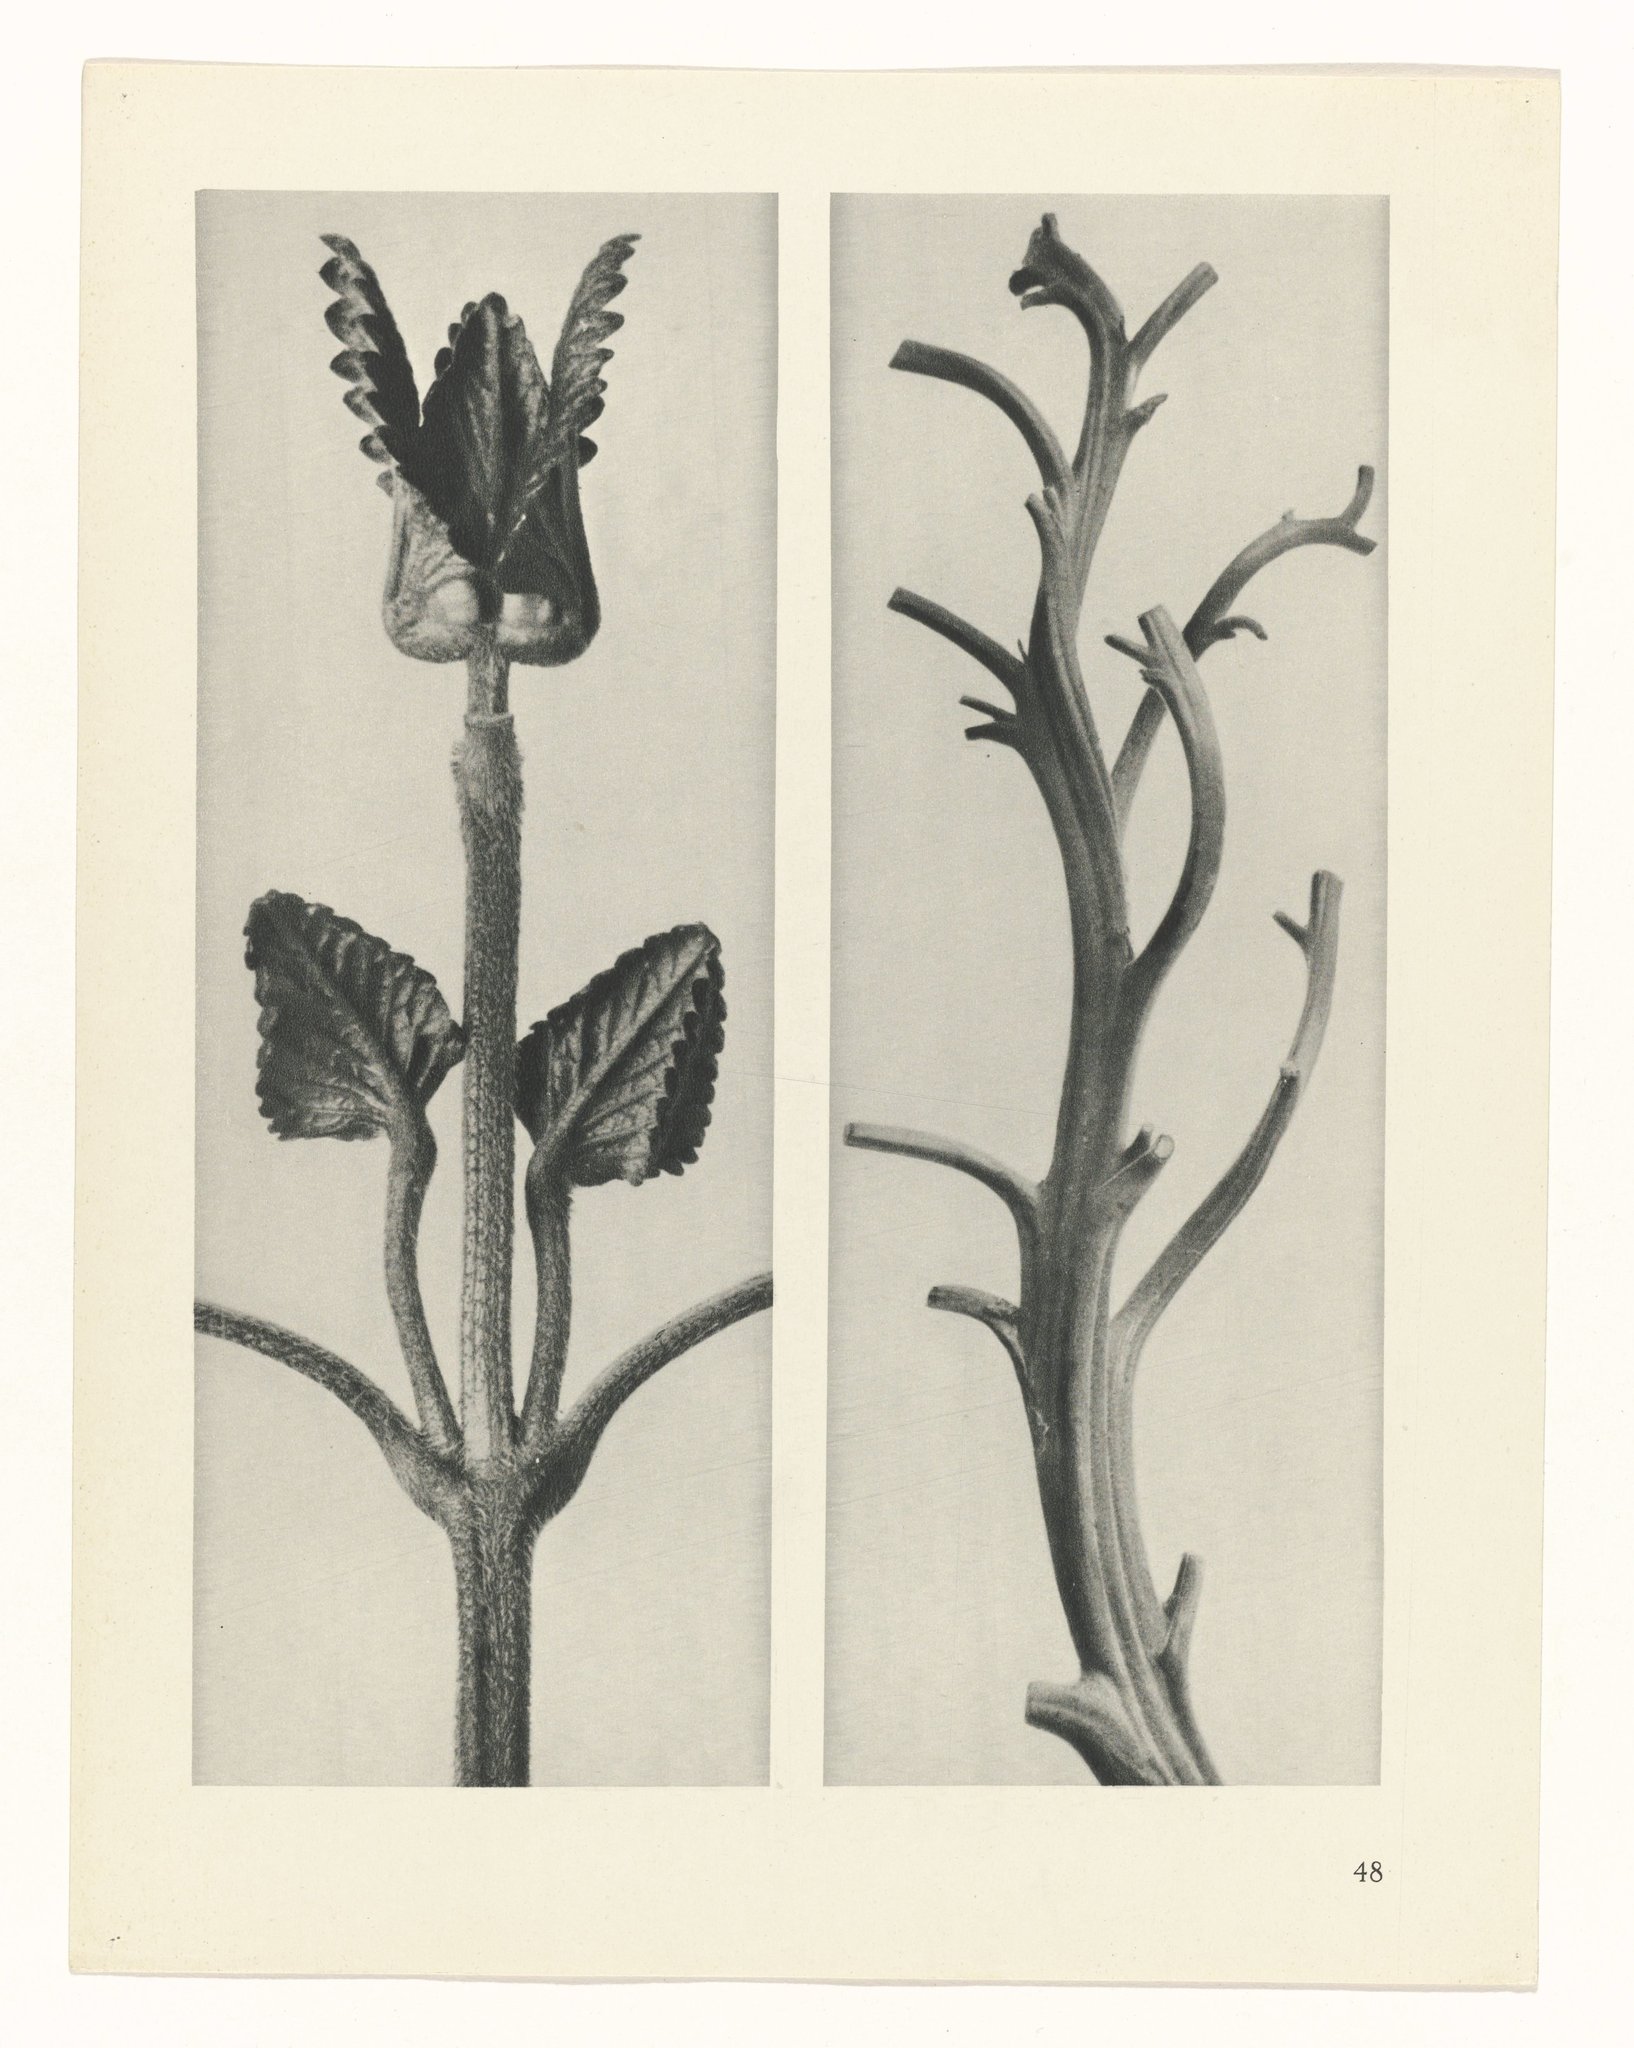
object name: photograph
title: Urformen der Kunst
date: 1928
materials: ink, paper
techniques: rotogravure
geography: berlin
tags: plants (in general)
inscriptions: number: ‘48’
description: facher Vergrößerung. Afkomstig uit losbladige uitgave.